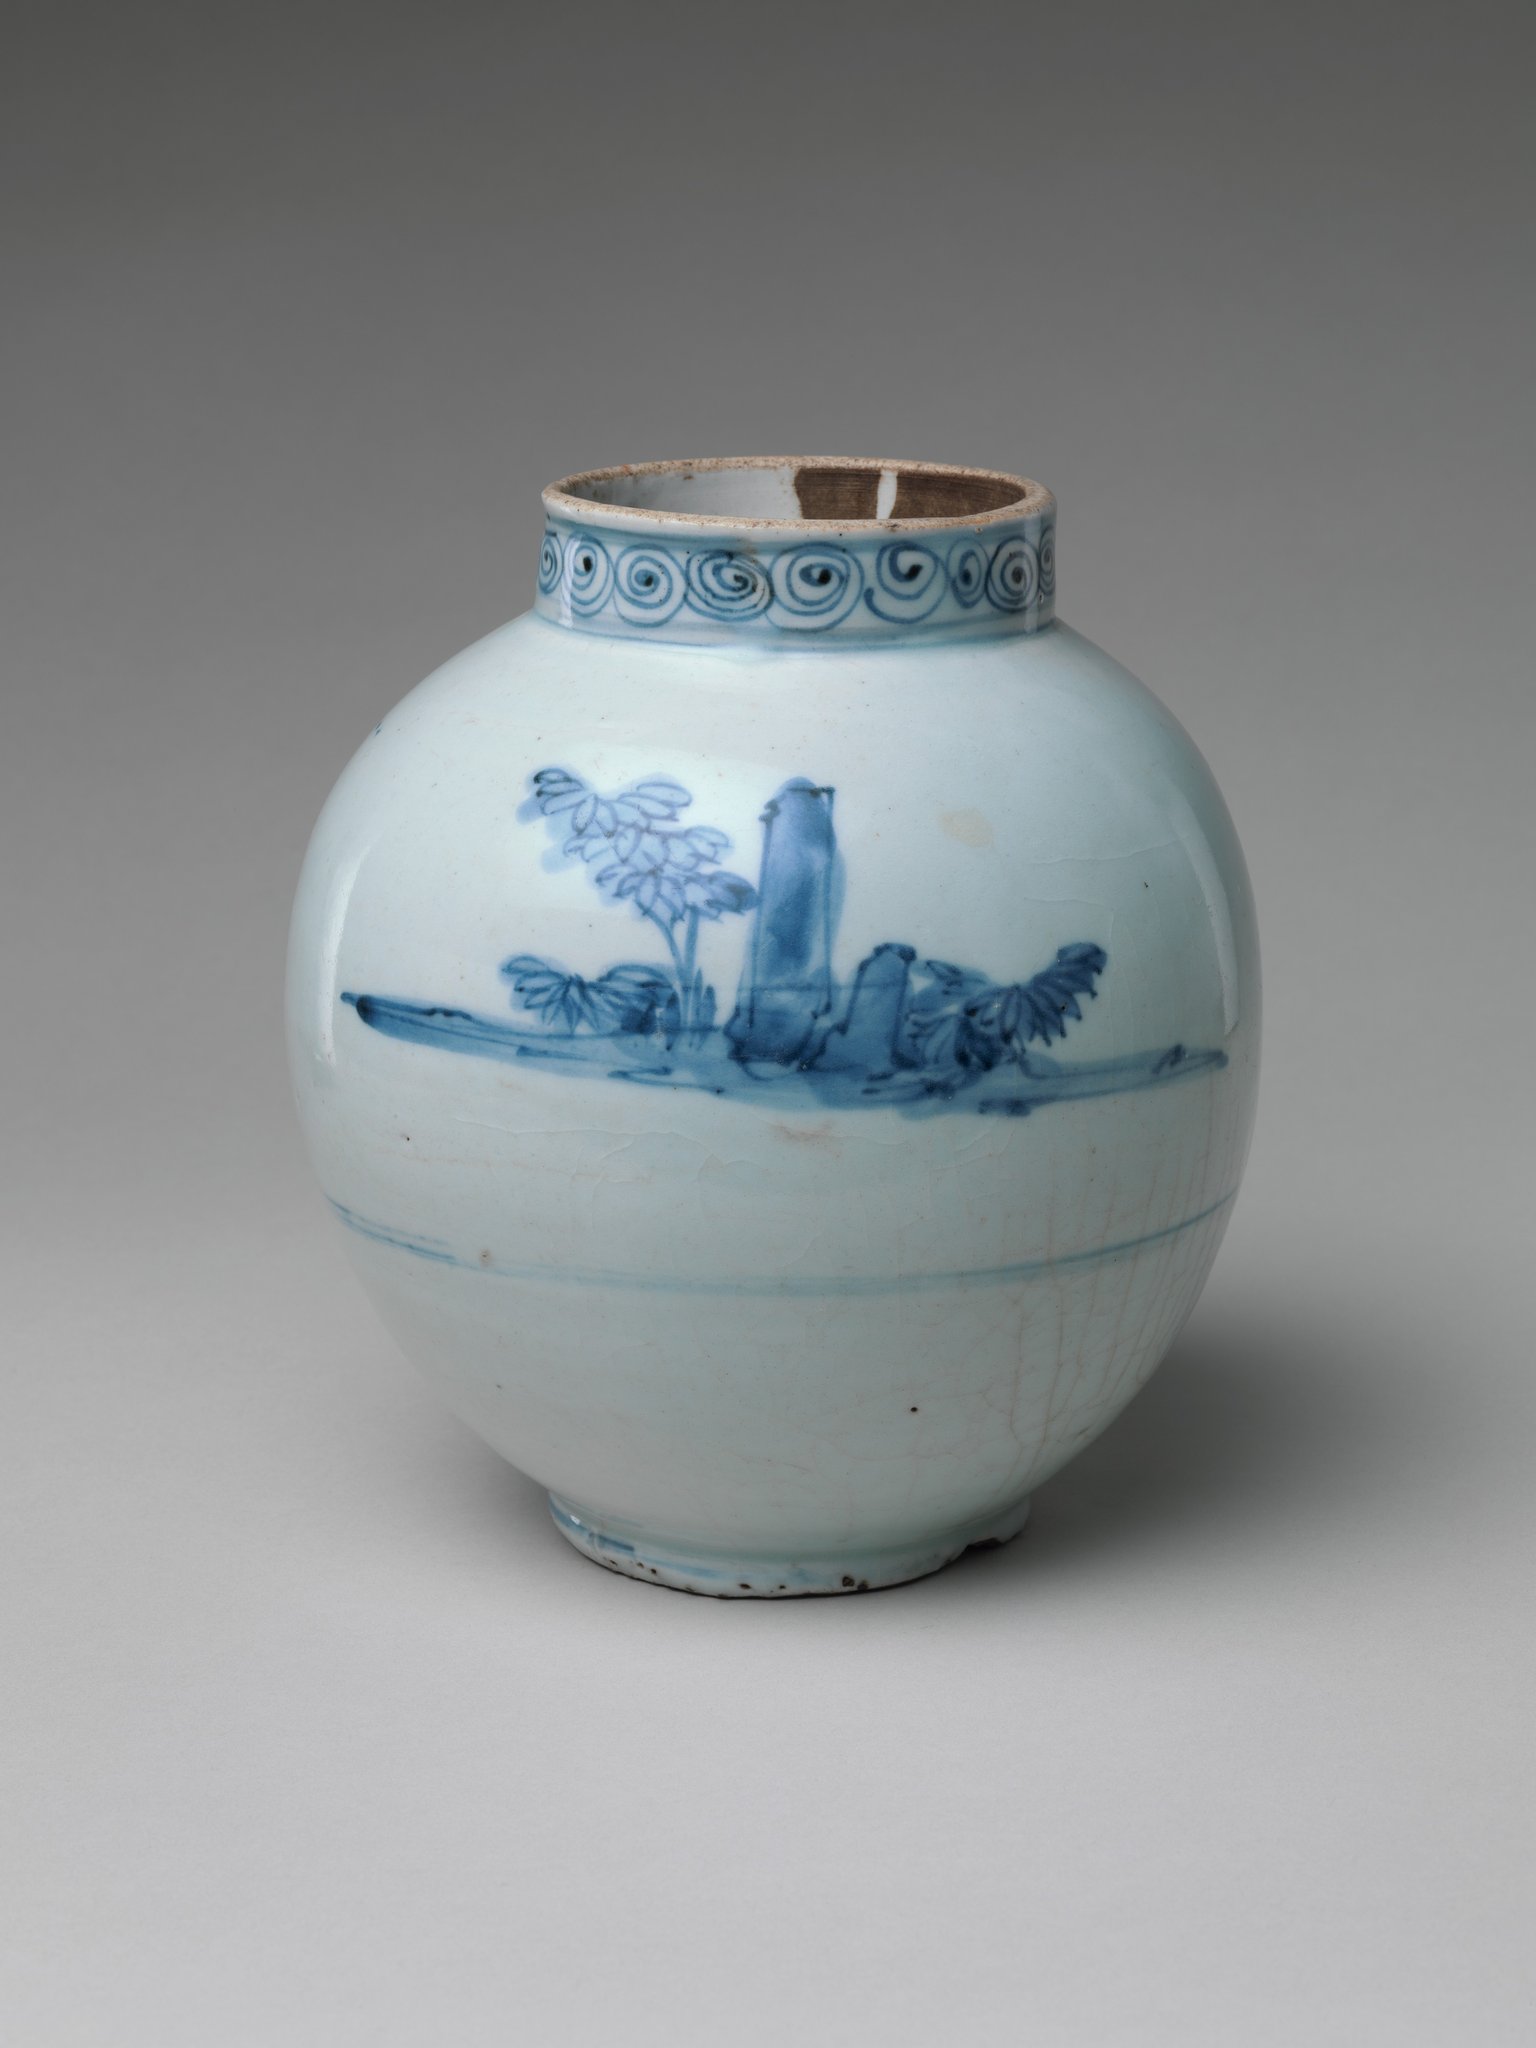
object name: jar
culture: japanese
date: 1625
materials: porcelain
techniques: painting, underglaze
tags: trees